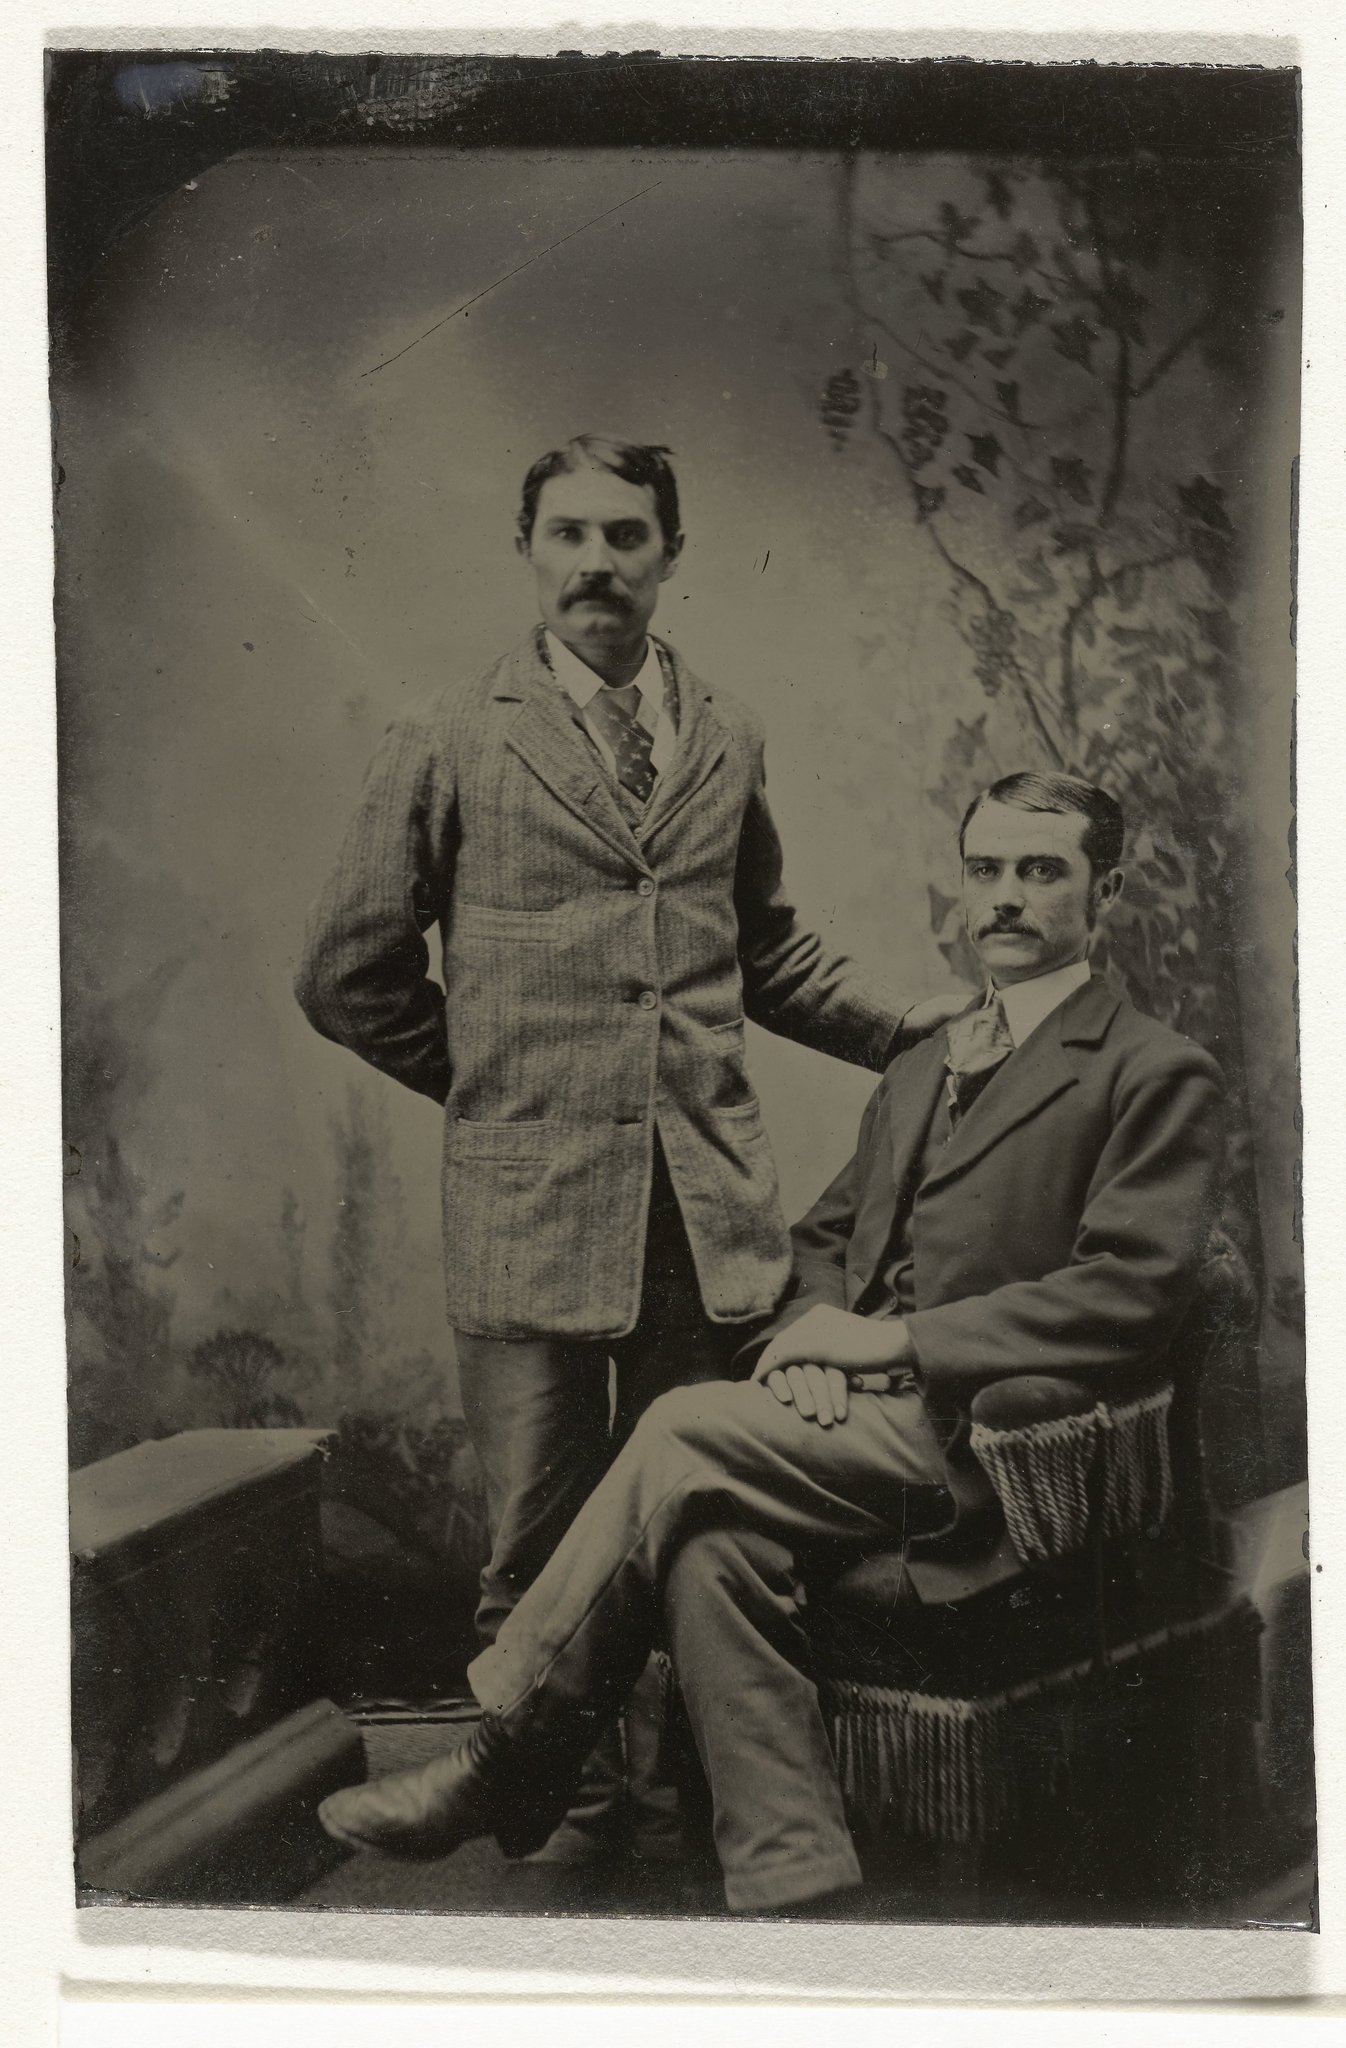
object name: photograph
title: Portrait of two men, one standing and one sitting, in front of a painted backdrop (leaves on a tree branch)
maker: Anonymous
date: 1895-1910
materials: metal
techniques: ferrotyping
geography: united states